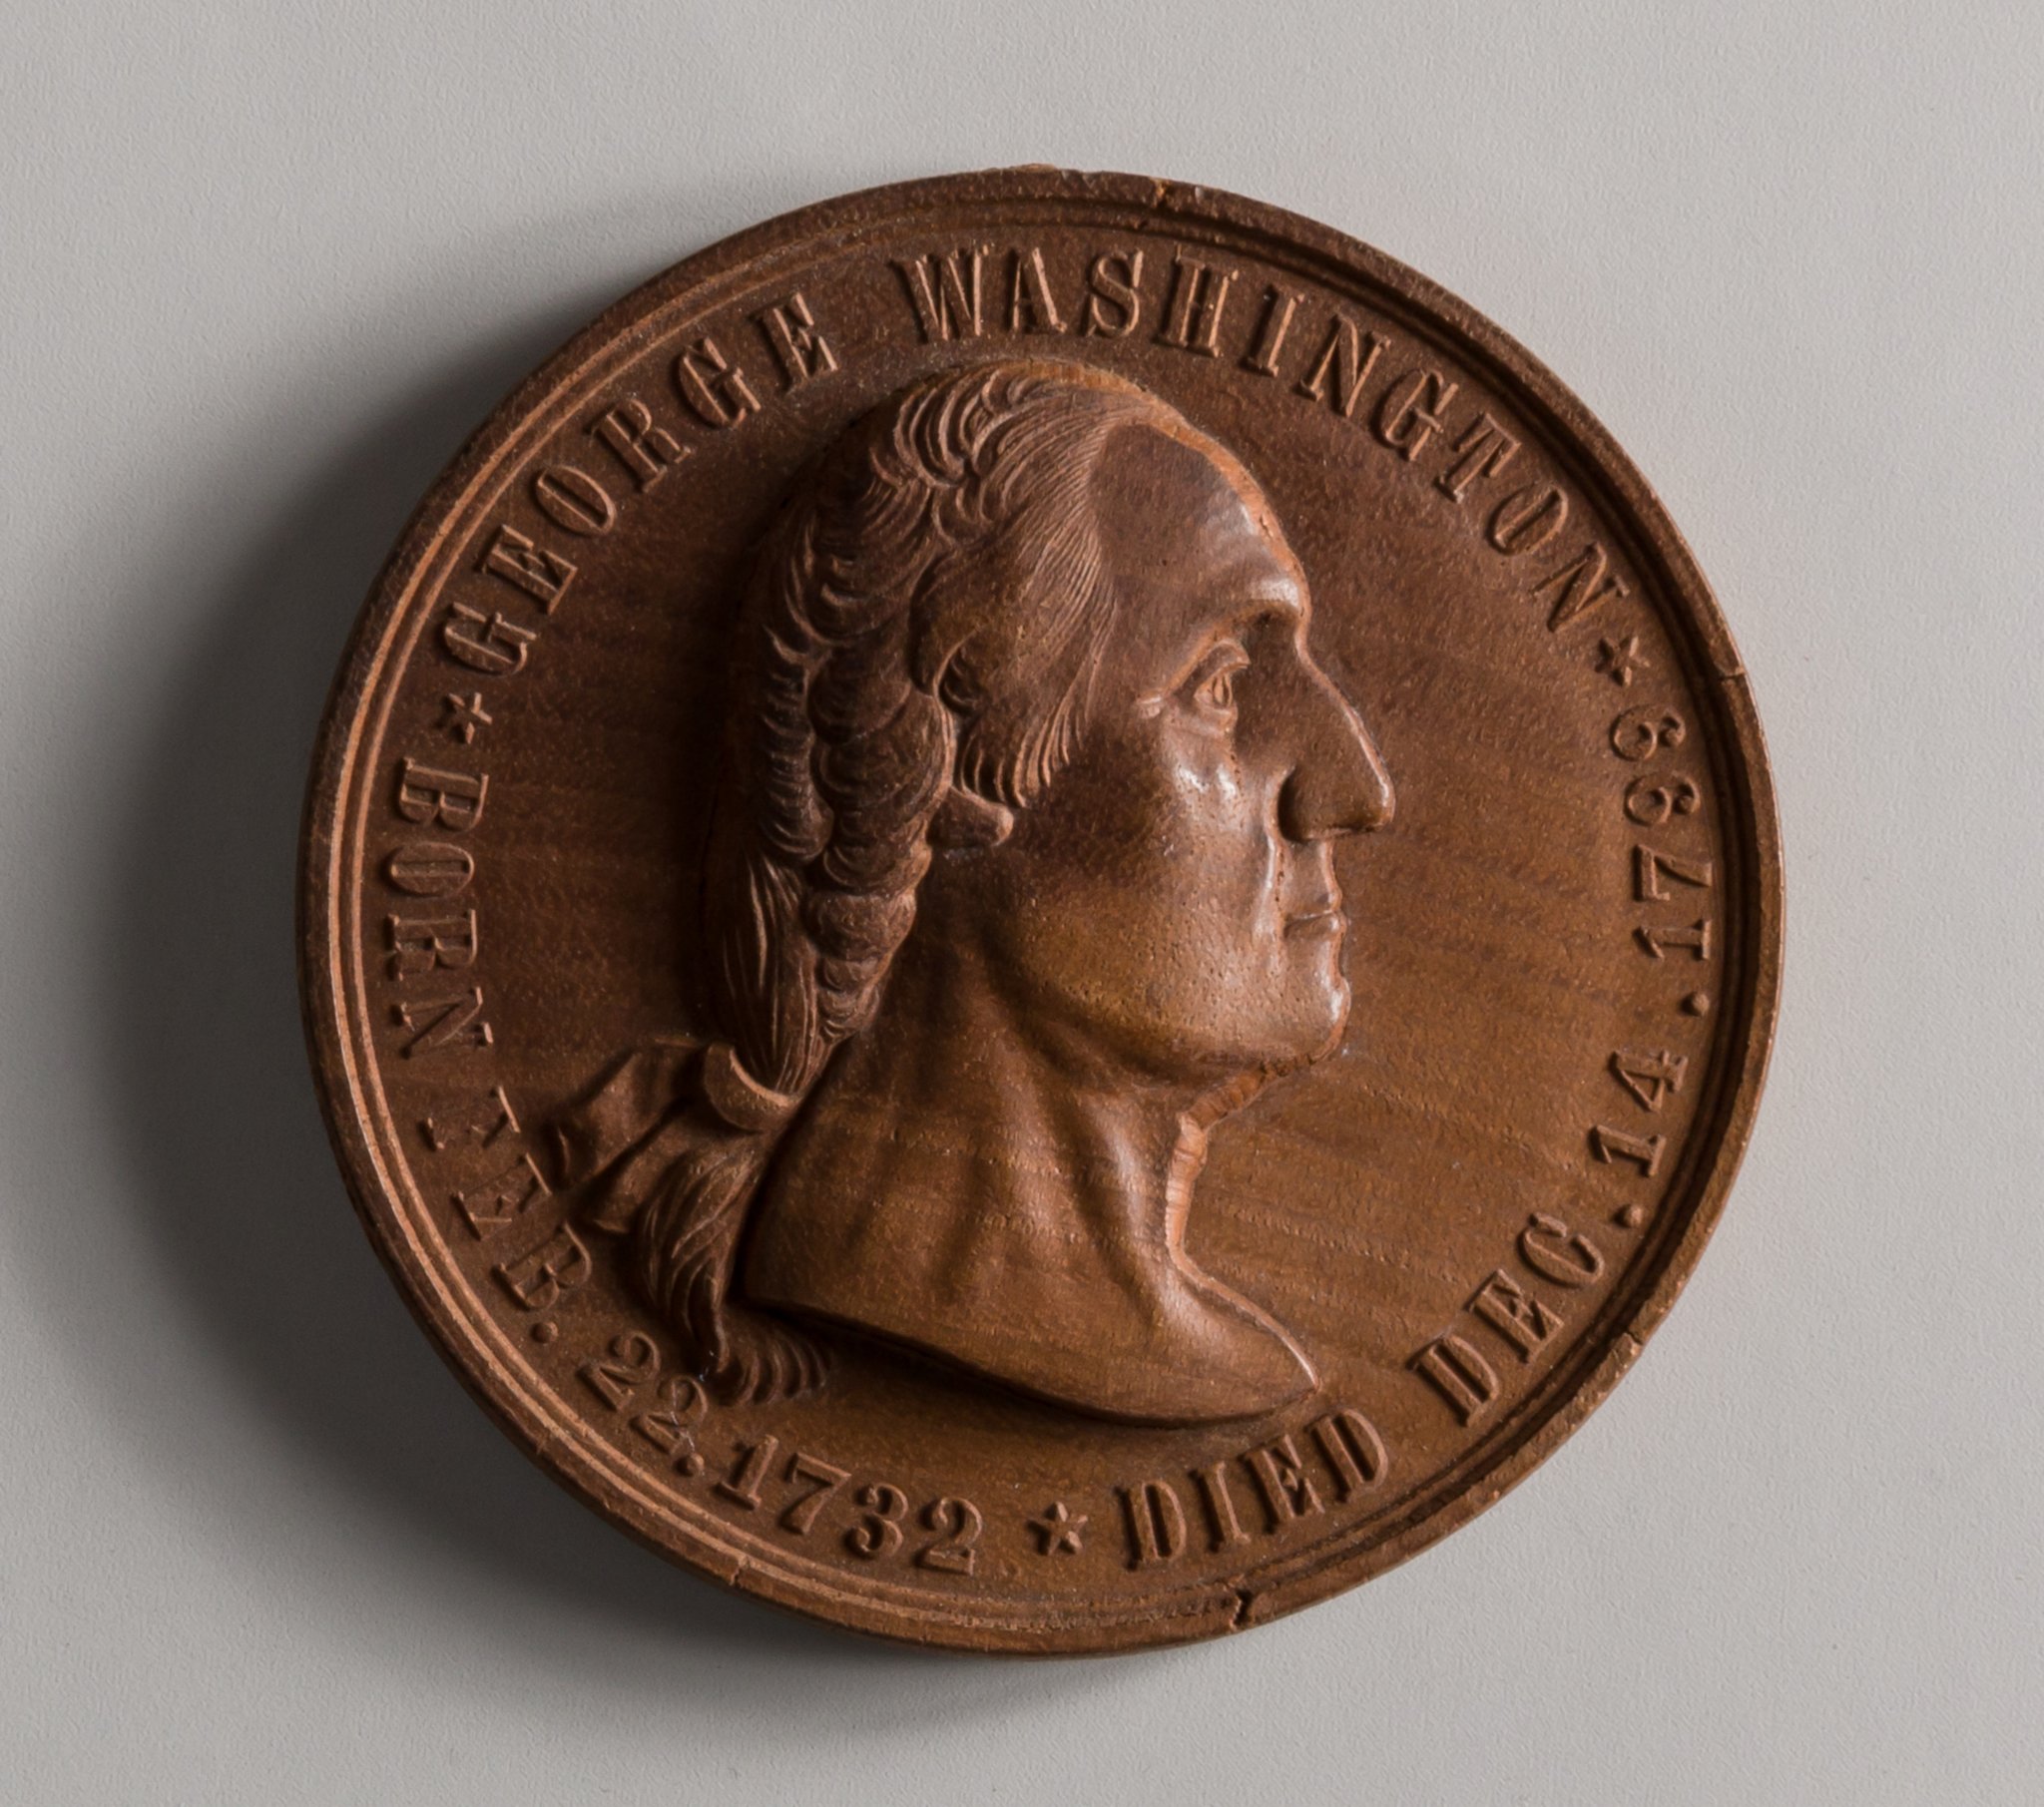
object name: medal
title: George Washington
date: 1876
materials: fiber, wood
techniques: pressed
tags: george washington,portraits,profiles